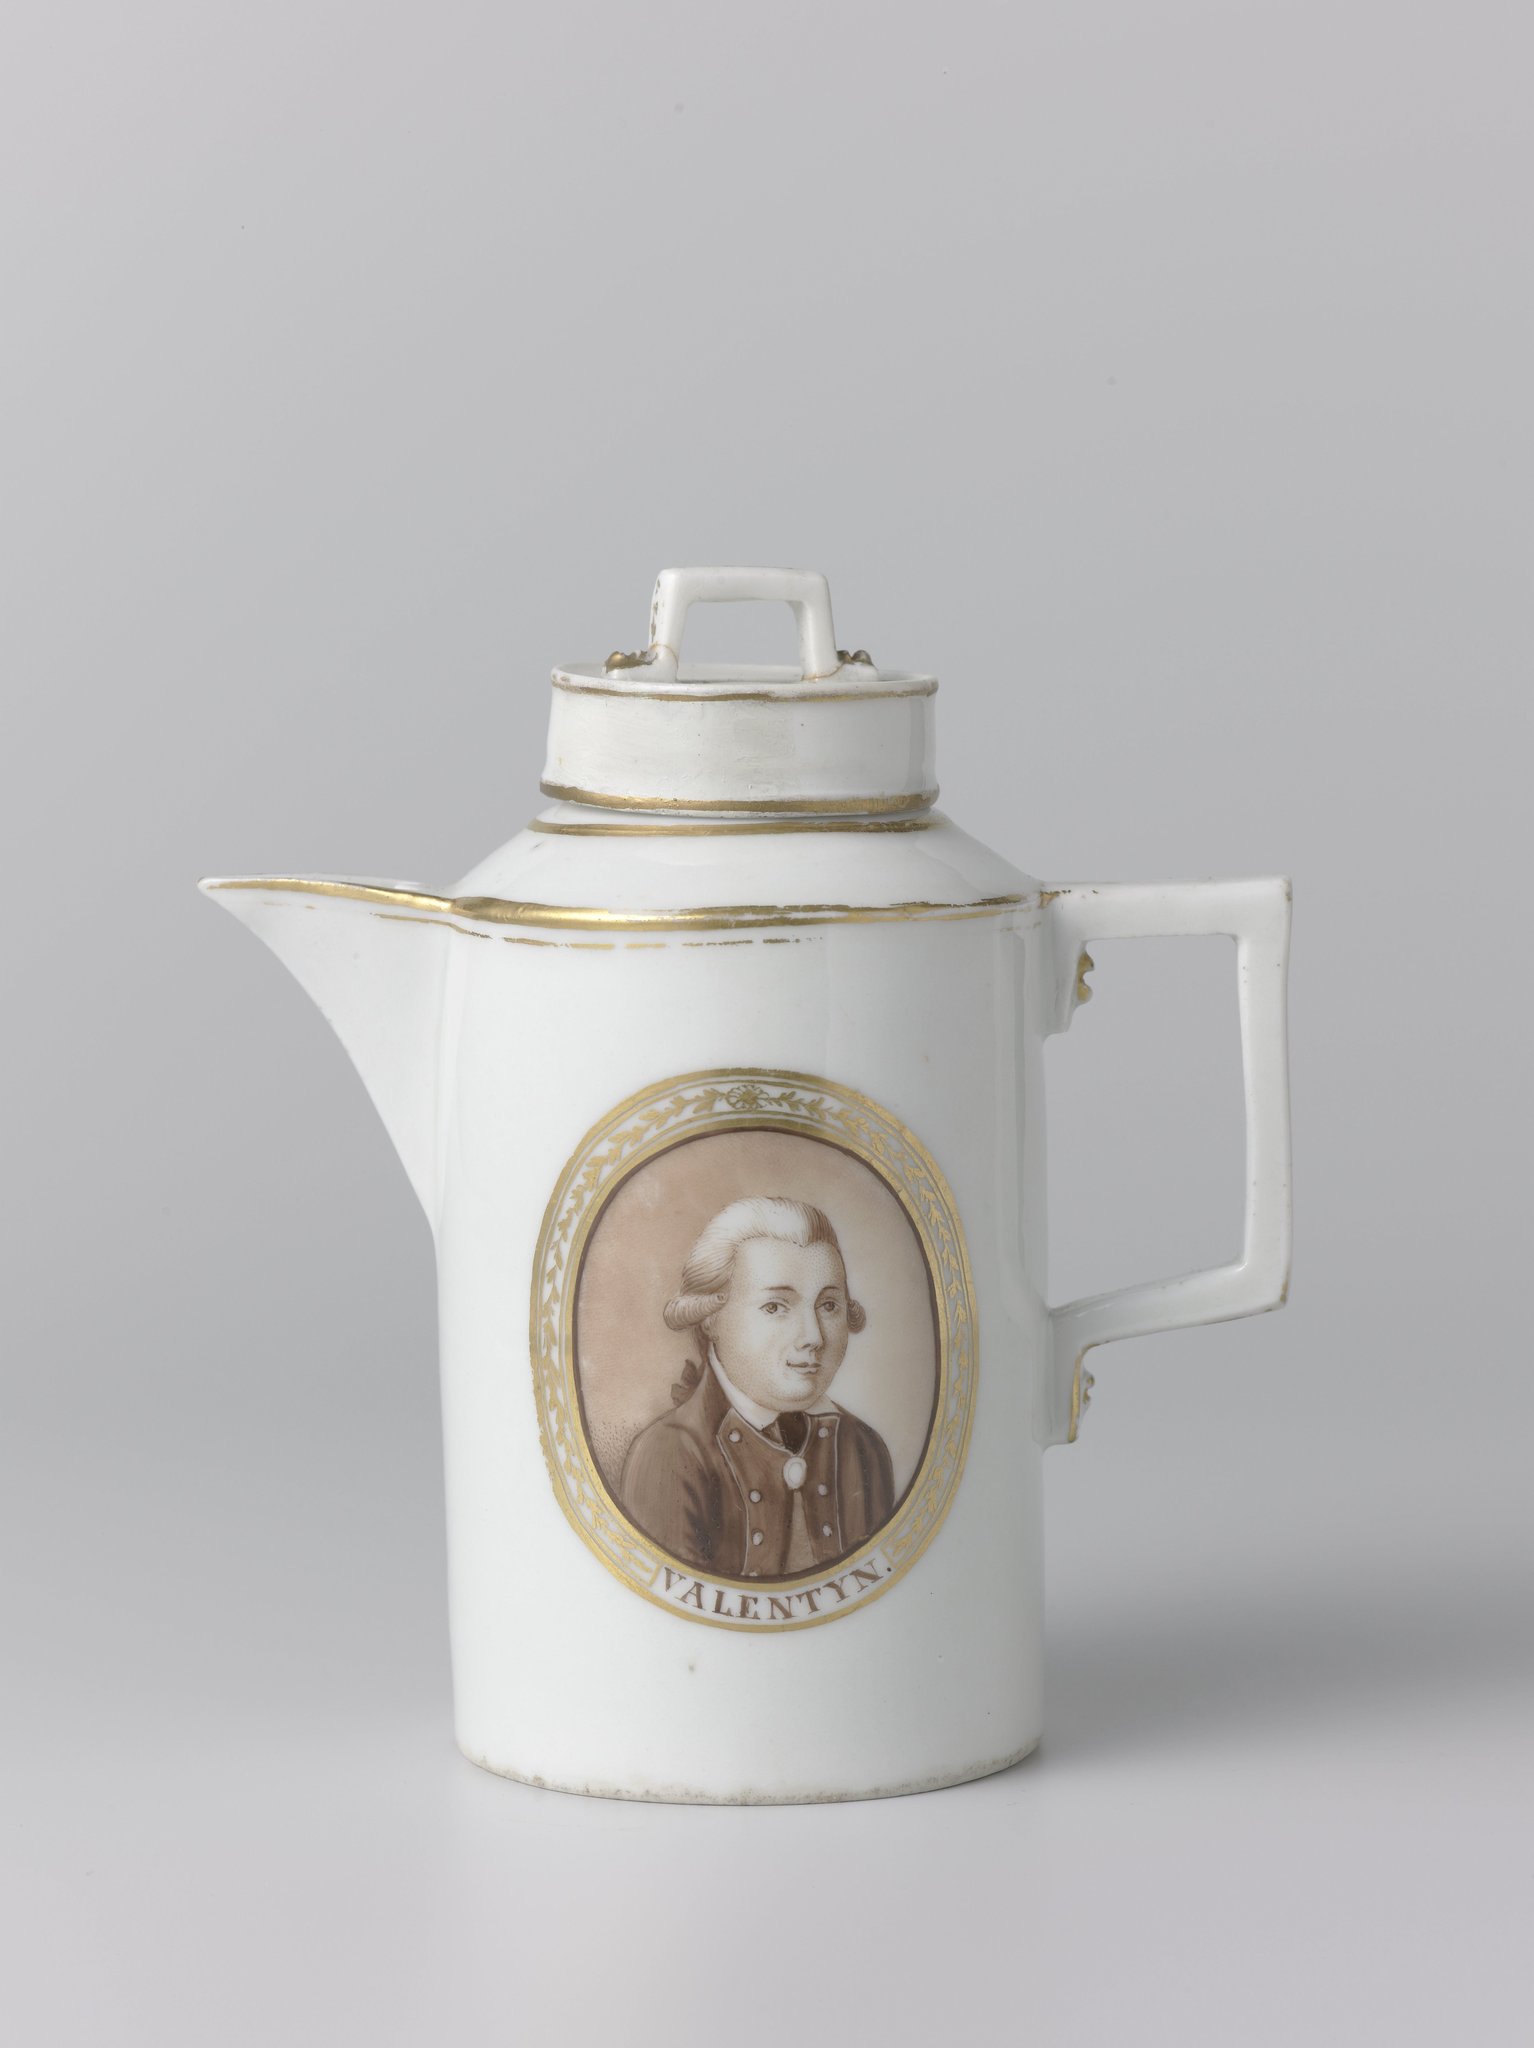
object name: service set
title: Milk jug with an image of the capture of Kattenburg and Abraham Valentijn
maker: Anonymous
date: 1794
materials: glaze, gold, paint, porcelain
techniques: firing, forming, gilding, turning, vitrification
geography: ilmenau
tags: abraham valentijn, kattenburg, inname van kattenburg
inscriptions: mark: ‘N-103’, inscription: ‘INNEMEN VAN KATTENBURG, 1787/ VALENTYN.’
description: Melkkan van porselein met een cilindrische wand, driehoekige tuit en hoekig oor, beschilderd op het glazuur in sepia en goud. Op de buik tweemaal een medaillon met in de ene een voorstelling van een slag met daaronder het opschrift 'INNEMEN VAN KATTENBURG, 1787' en in de andere een protret met het opschrift 'VALENTYN.'. Een band met een bladrank om de medaillons. Bladrank op het oor en het hoekige handvat van de deksel. Gemerkt op de onderzijde met N-103